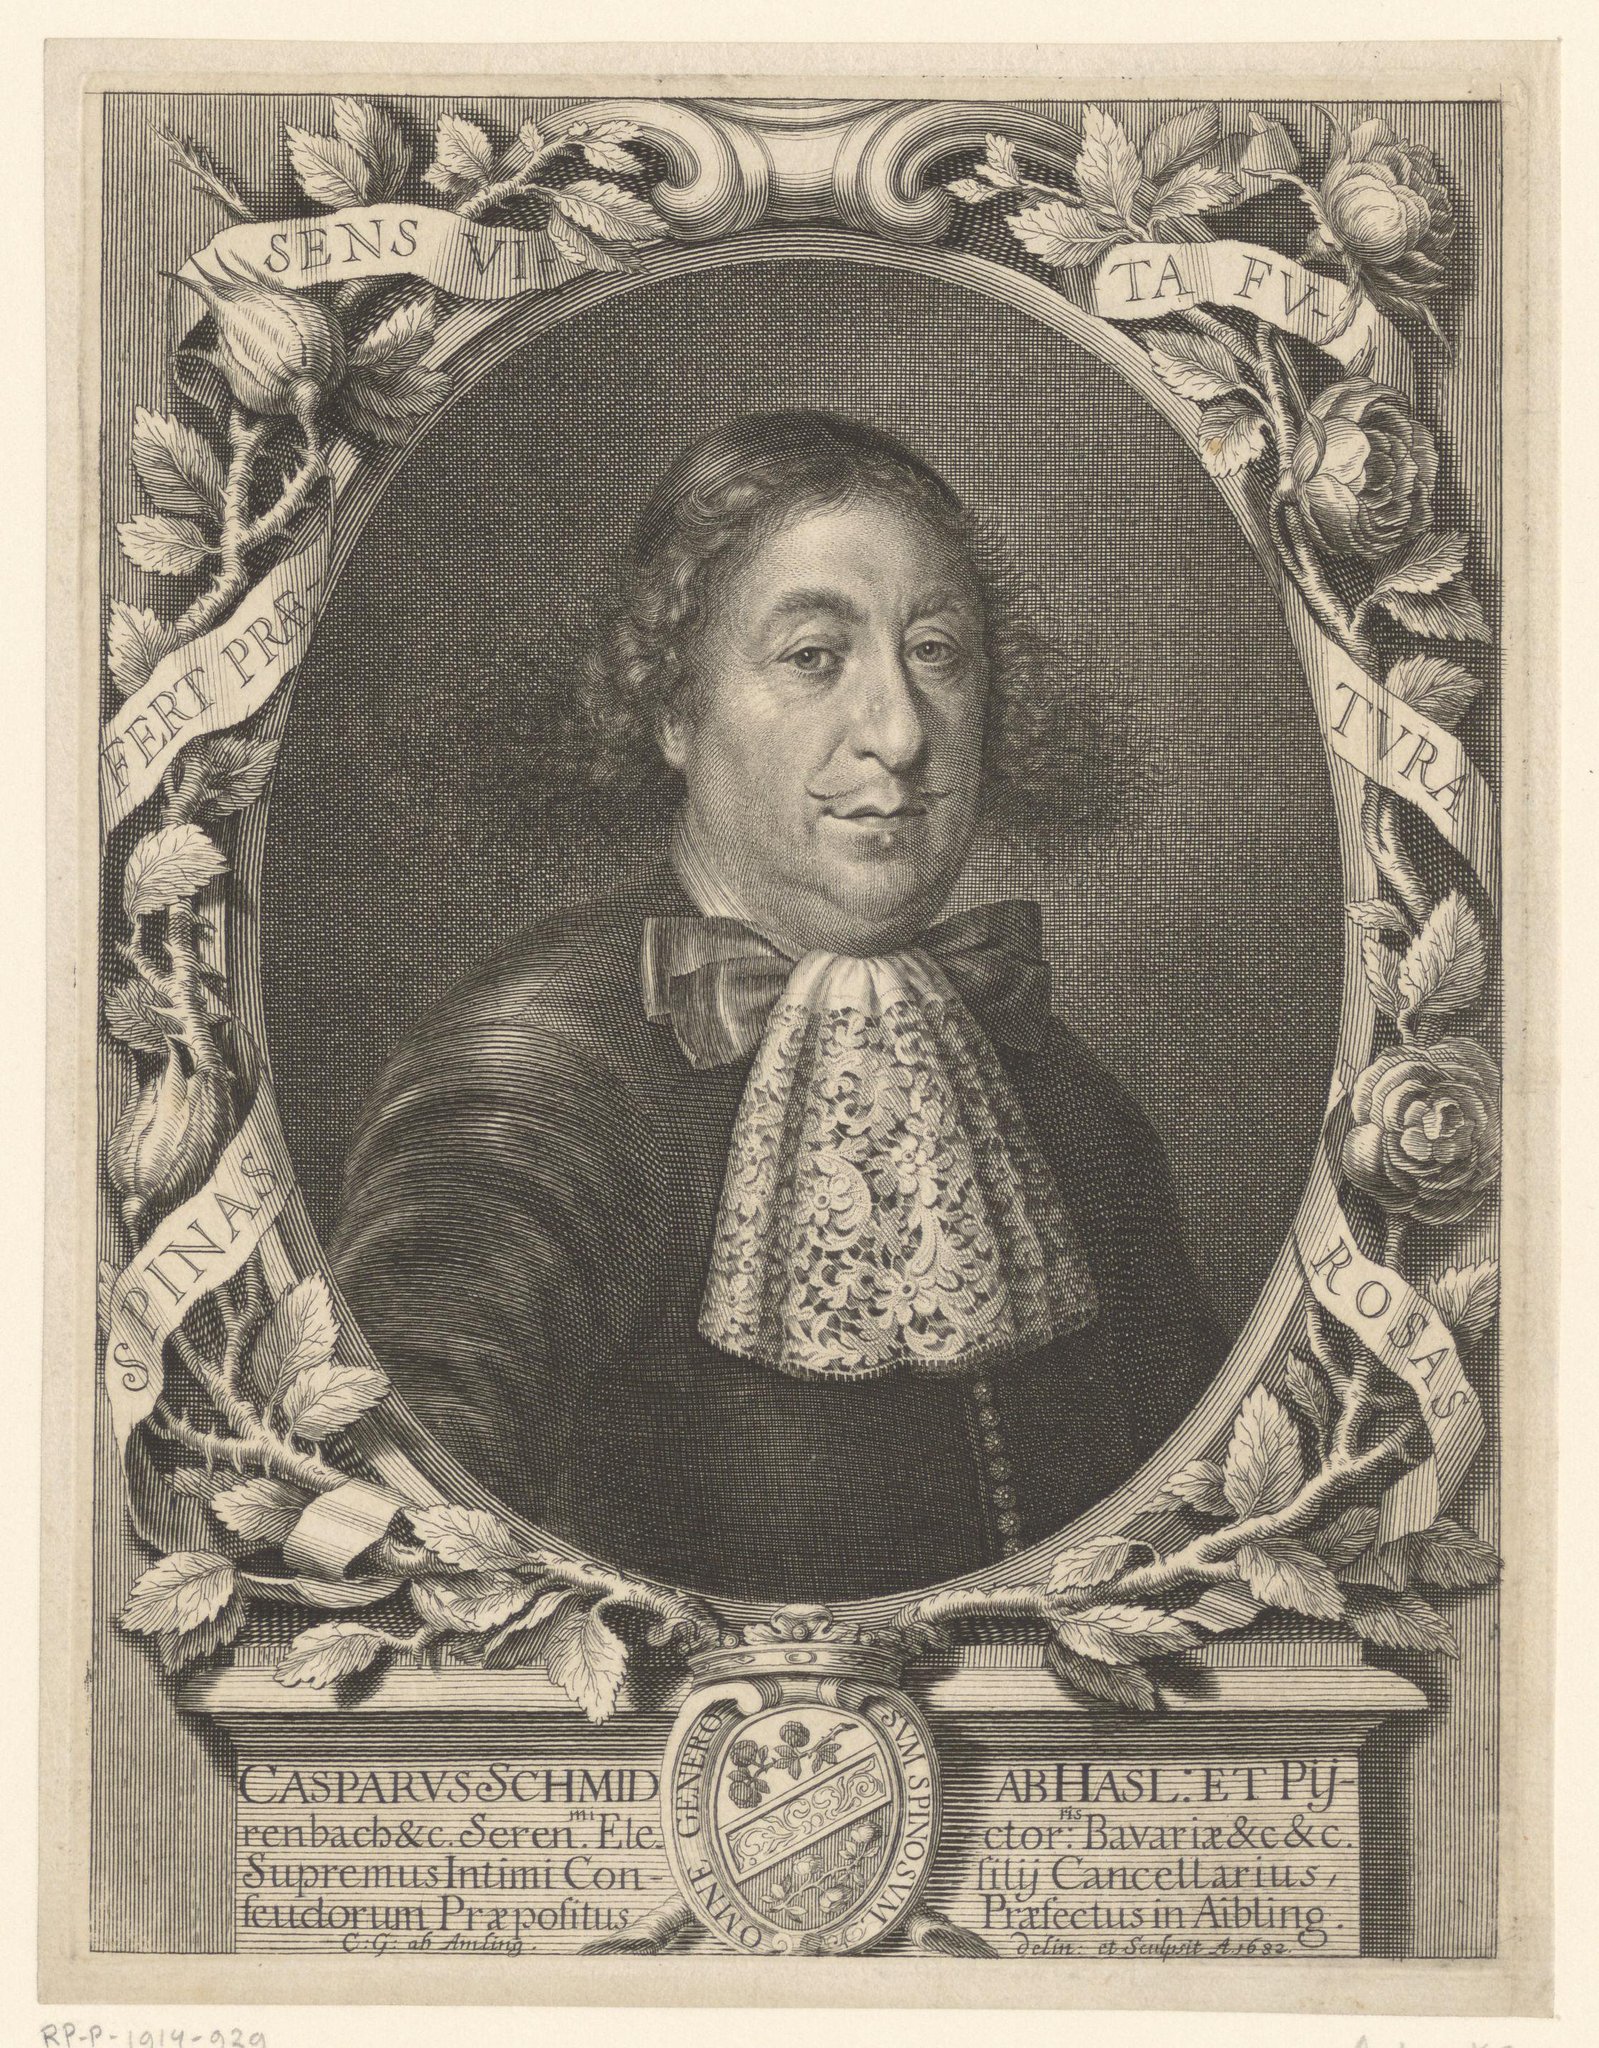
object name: print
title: Portret van Kaspar Schmid von Haslbach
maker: karl gustav amling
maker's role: print maker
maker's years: 1651-1702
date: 1682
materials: paper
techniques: engraving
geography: munich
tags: historical persons, armorial bearing, heraldry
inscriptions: collector's mark: Lugt 2228